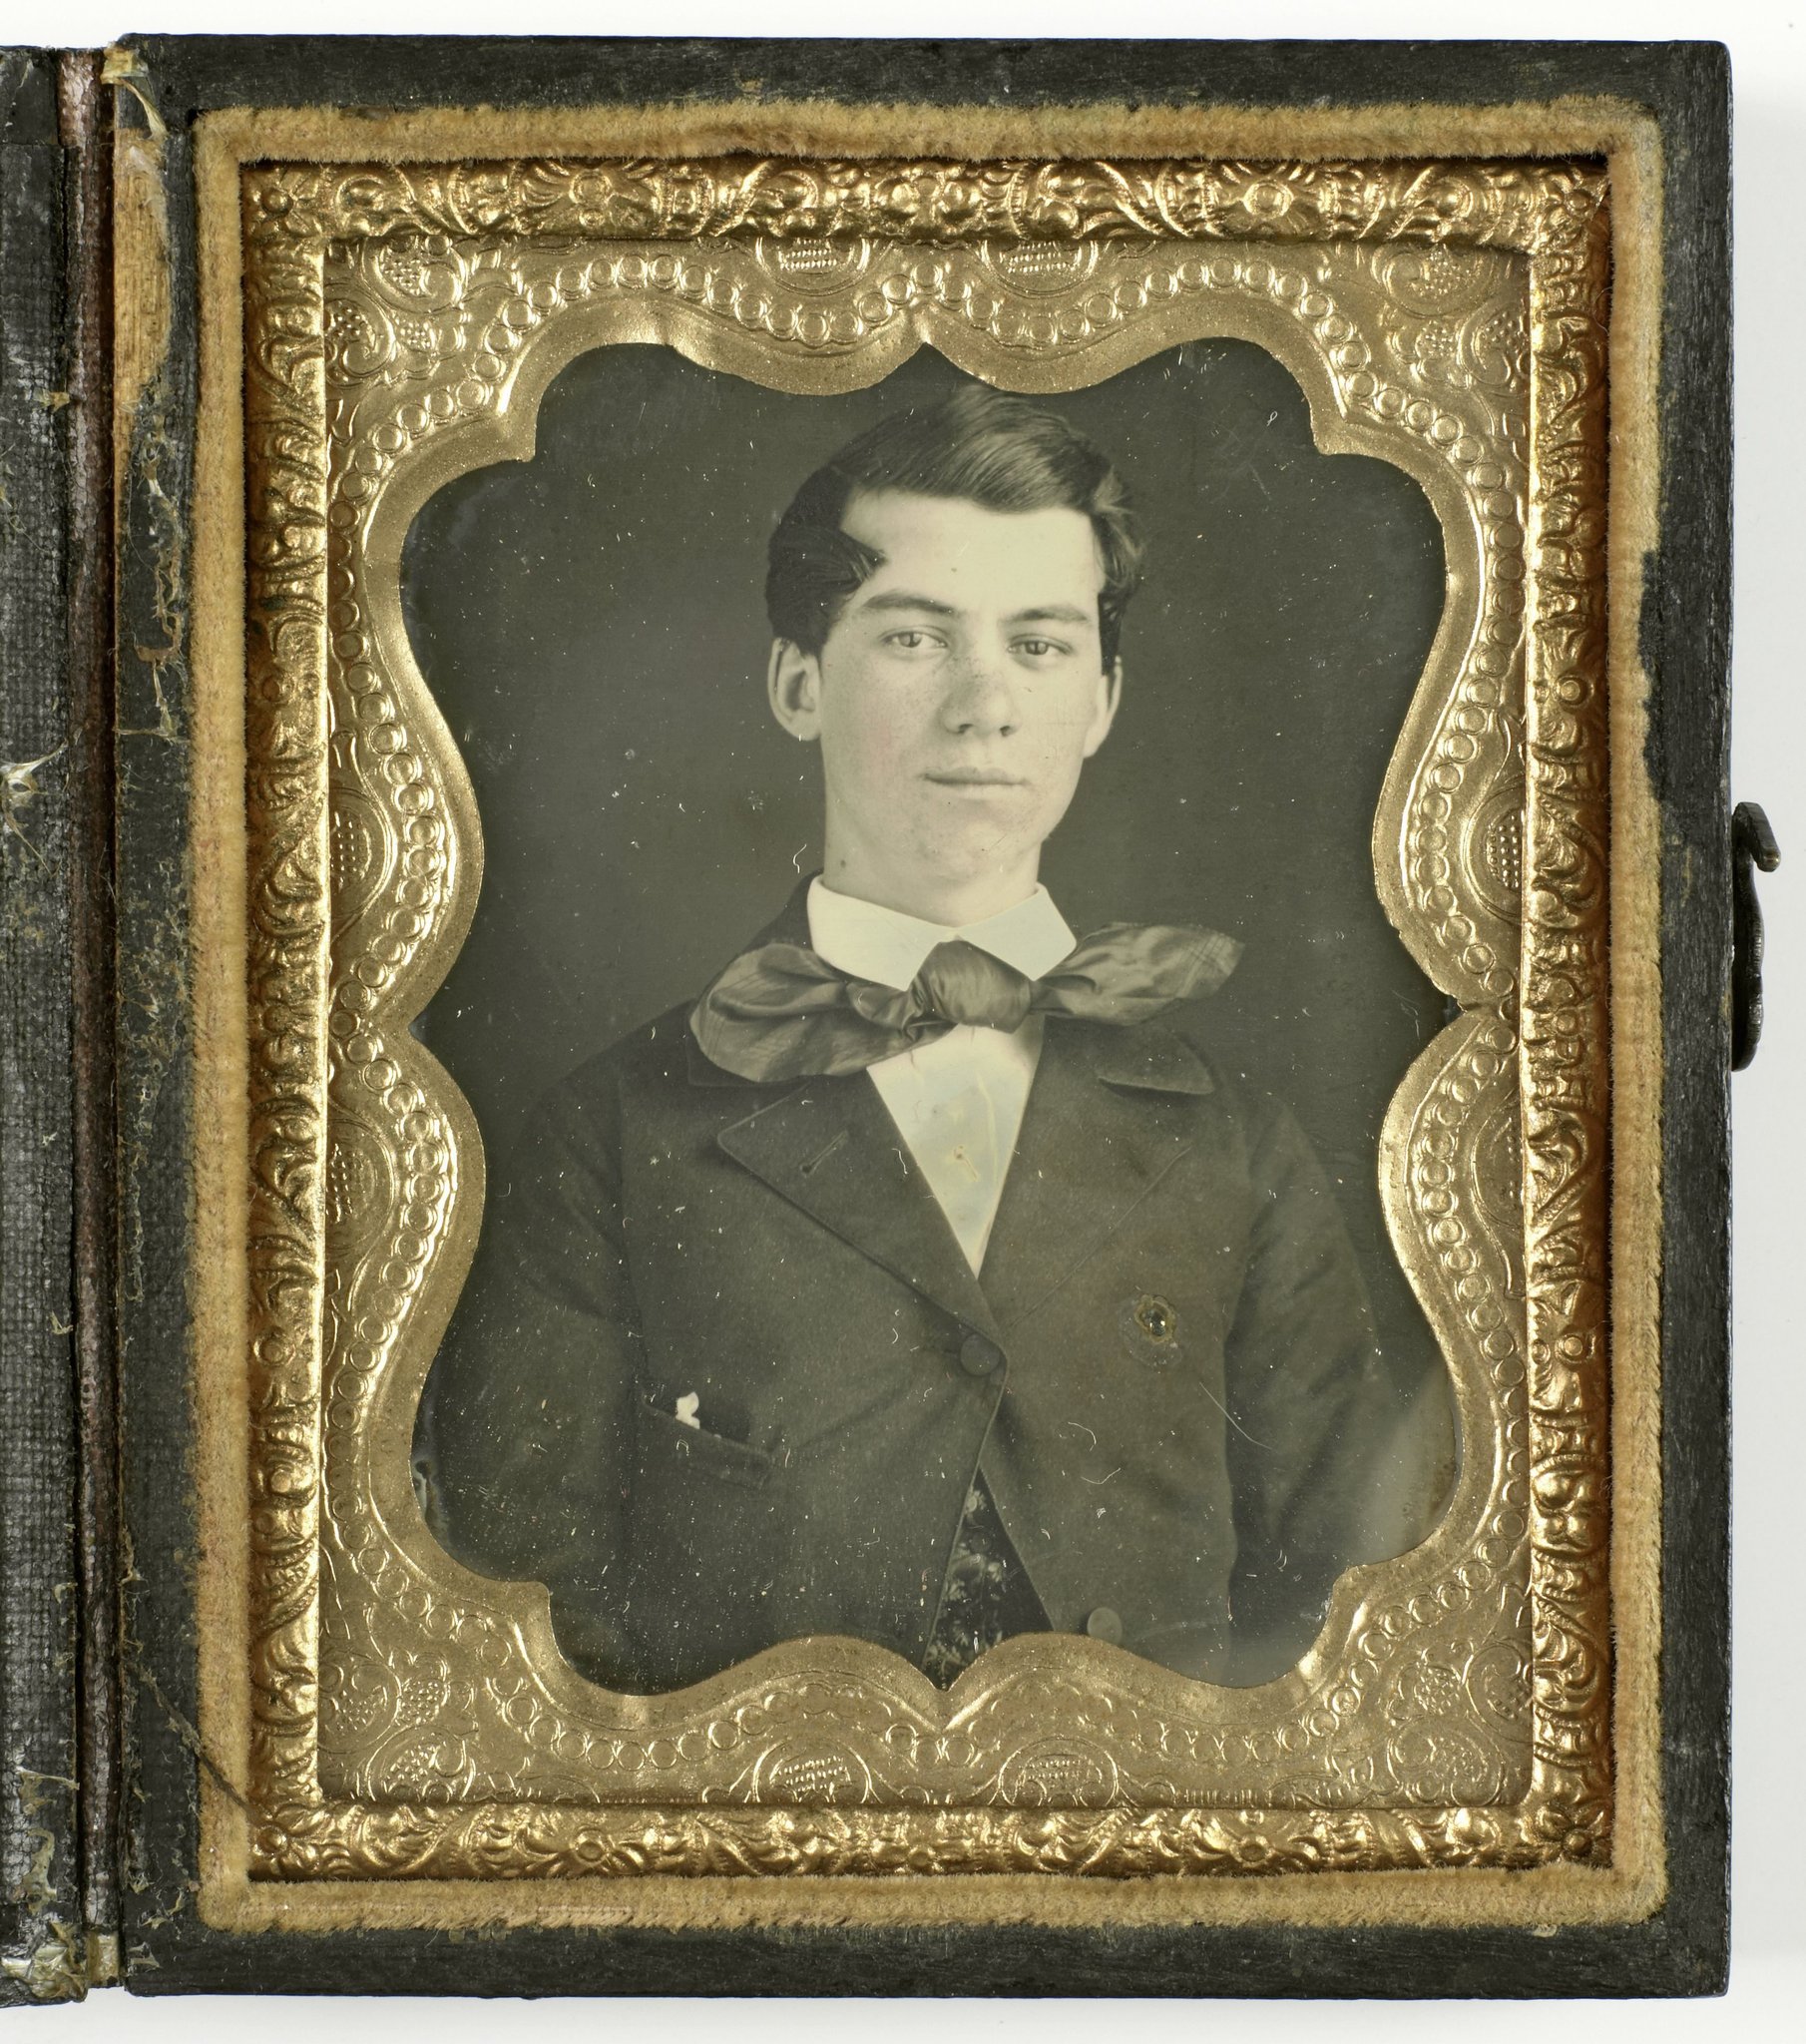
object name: photograph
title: Portret van een onbekende jonge man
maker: Anonymous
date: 1840-1860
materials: copper, glass, leather, velvet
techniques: daguerreotype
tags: historical persons, youth, adolescent